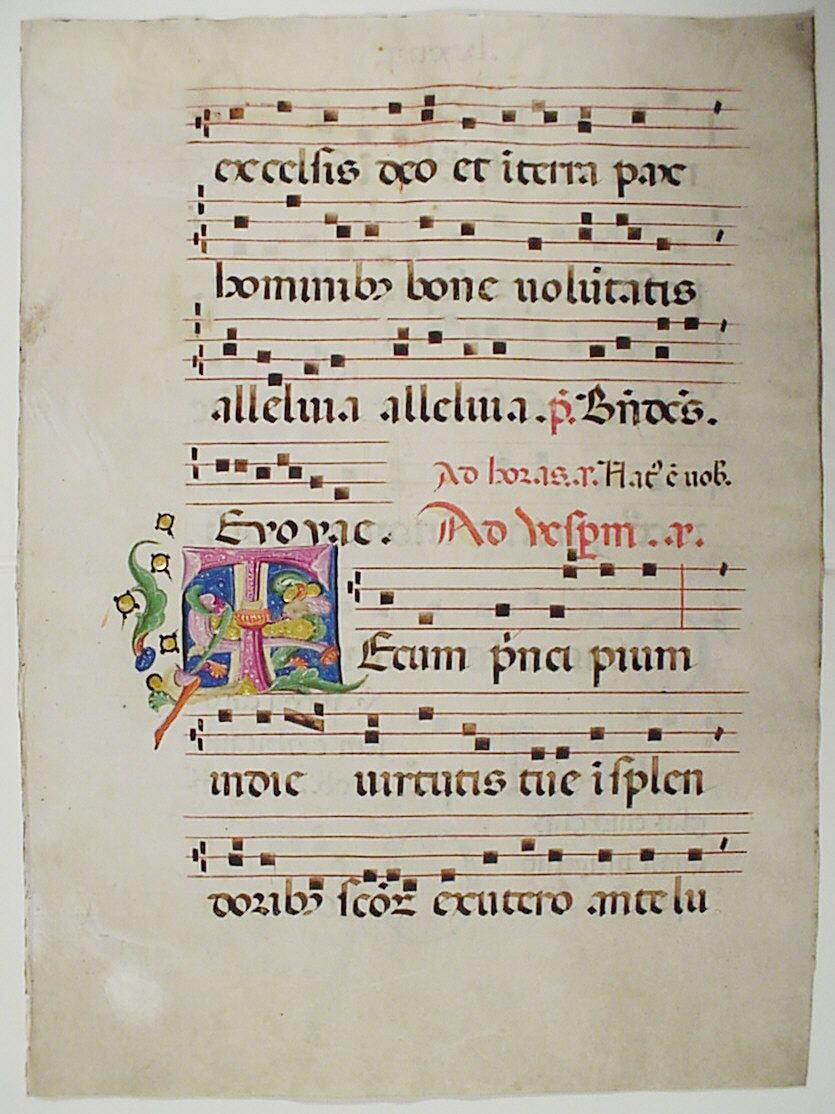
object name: antiphonary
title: Manuscript Leaf with Initial T, from an Antiphonary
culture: italian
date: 1401-1500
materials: ink, metal leaf, parchment, paint